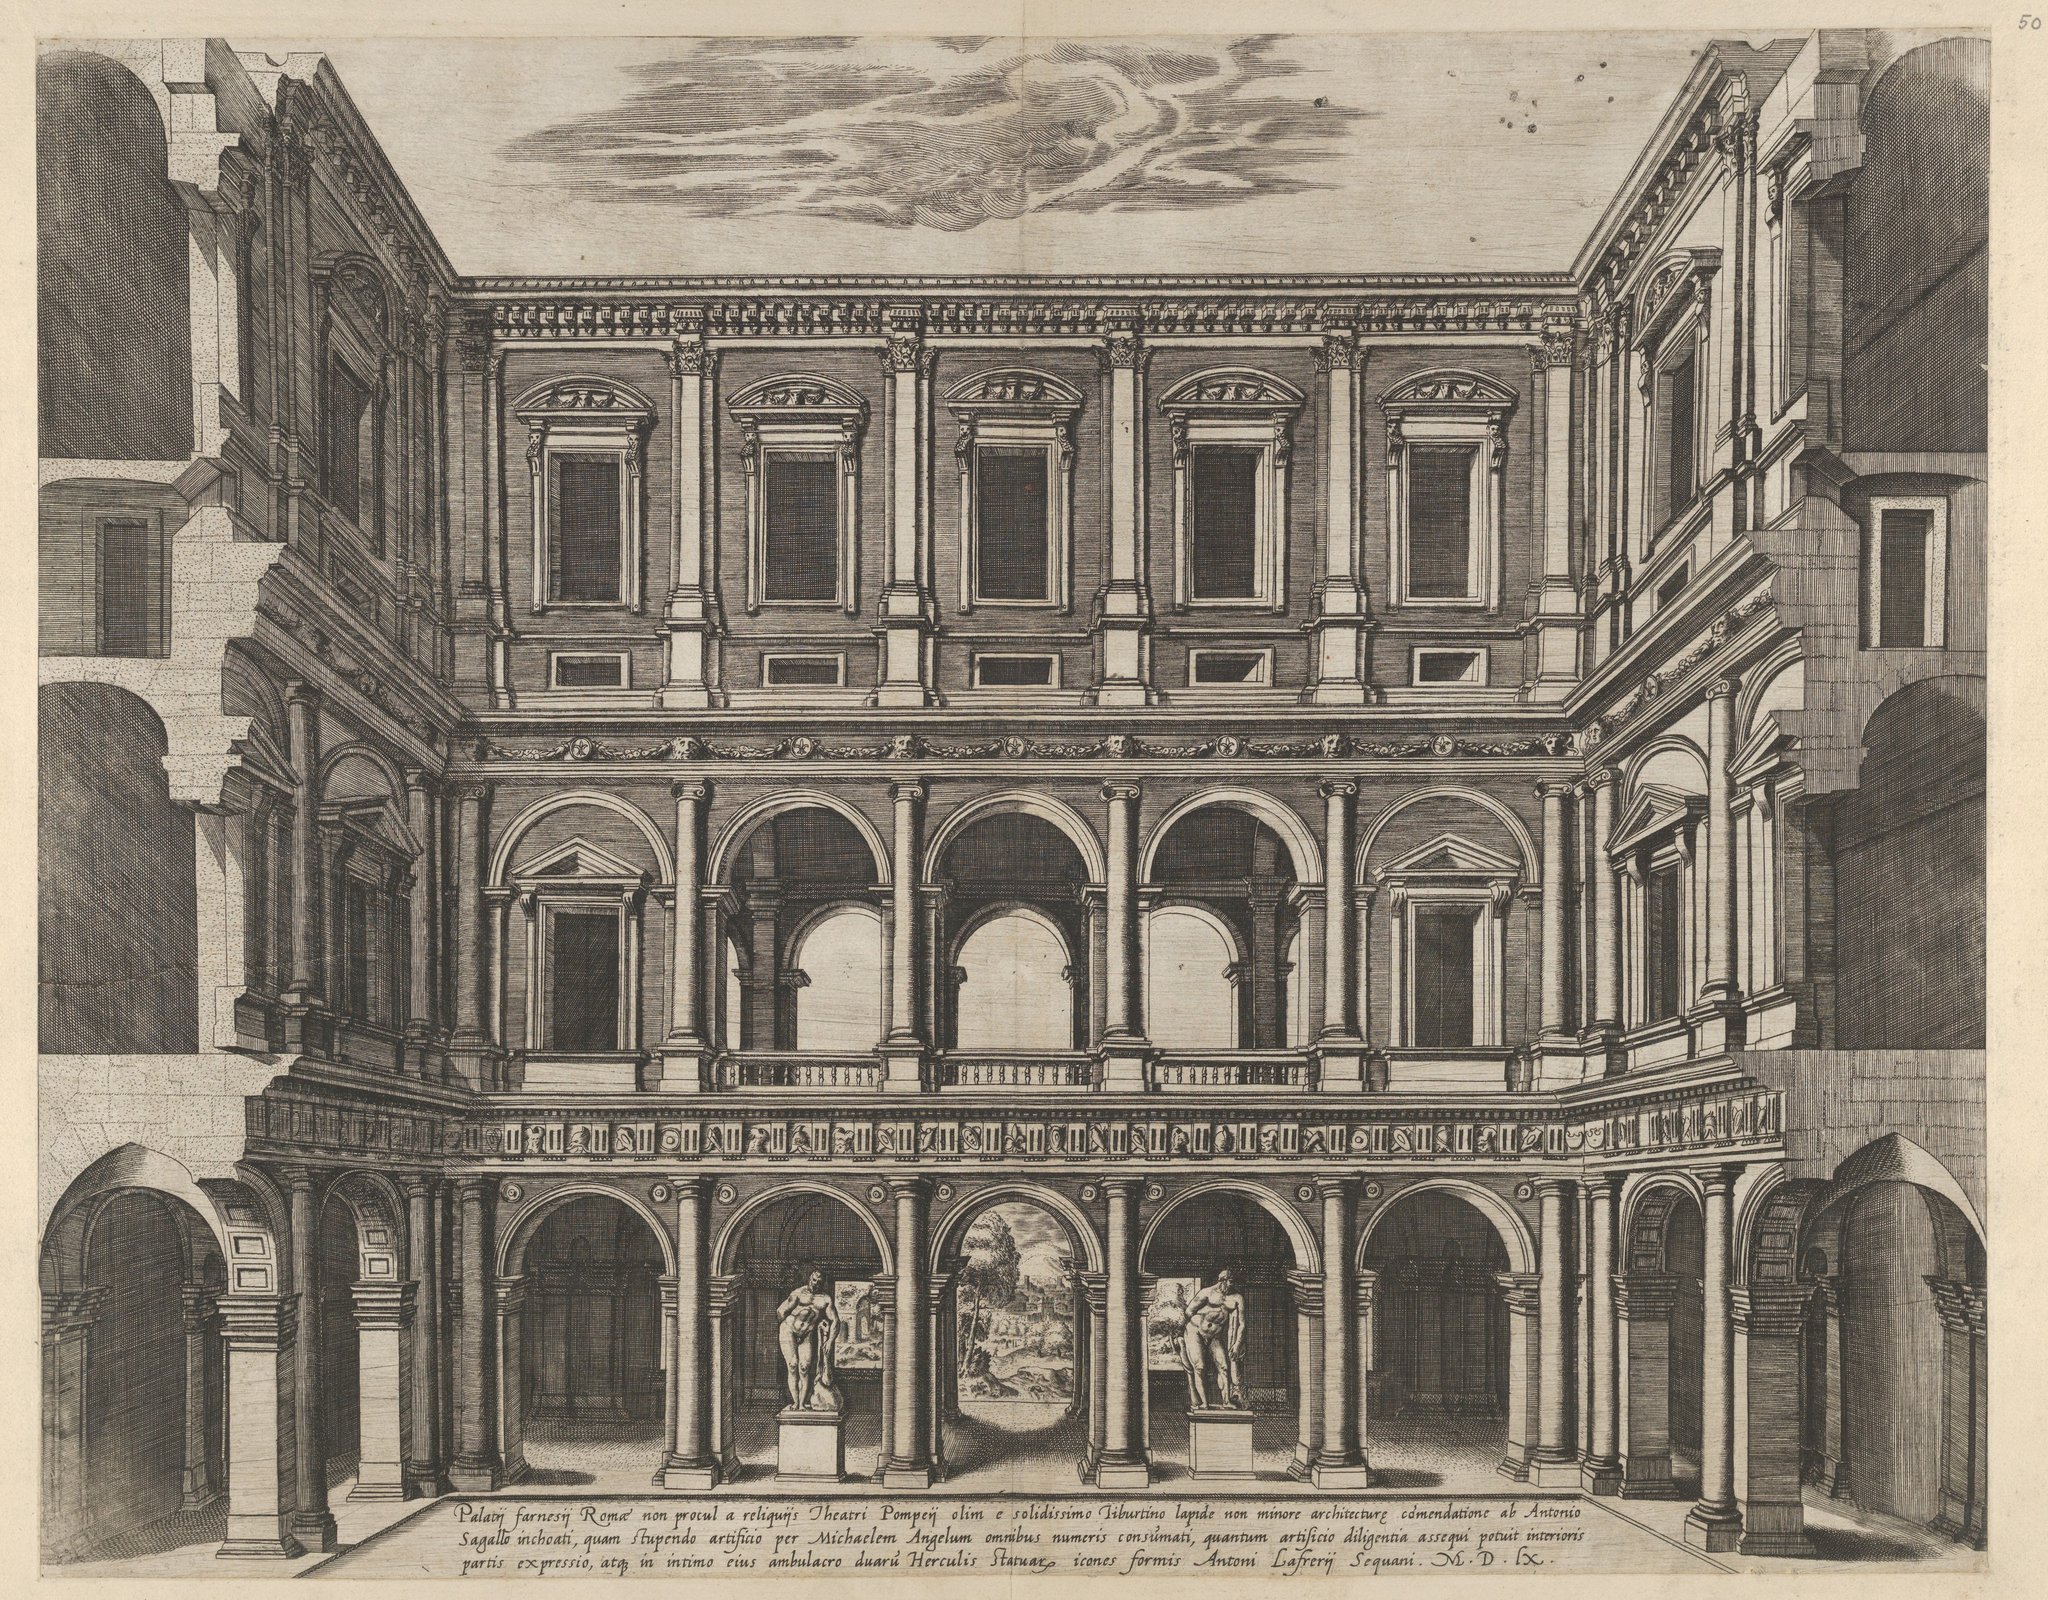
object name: print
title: Farnese Palace Interior, from "Speculum Romanae Magnificentiae"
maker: Anonymous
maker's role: artist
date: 1560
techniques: engraving, etching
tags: architecture,palaces,interiors,rome